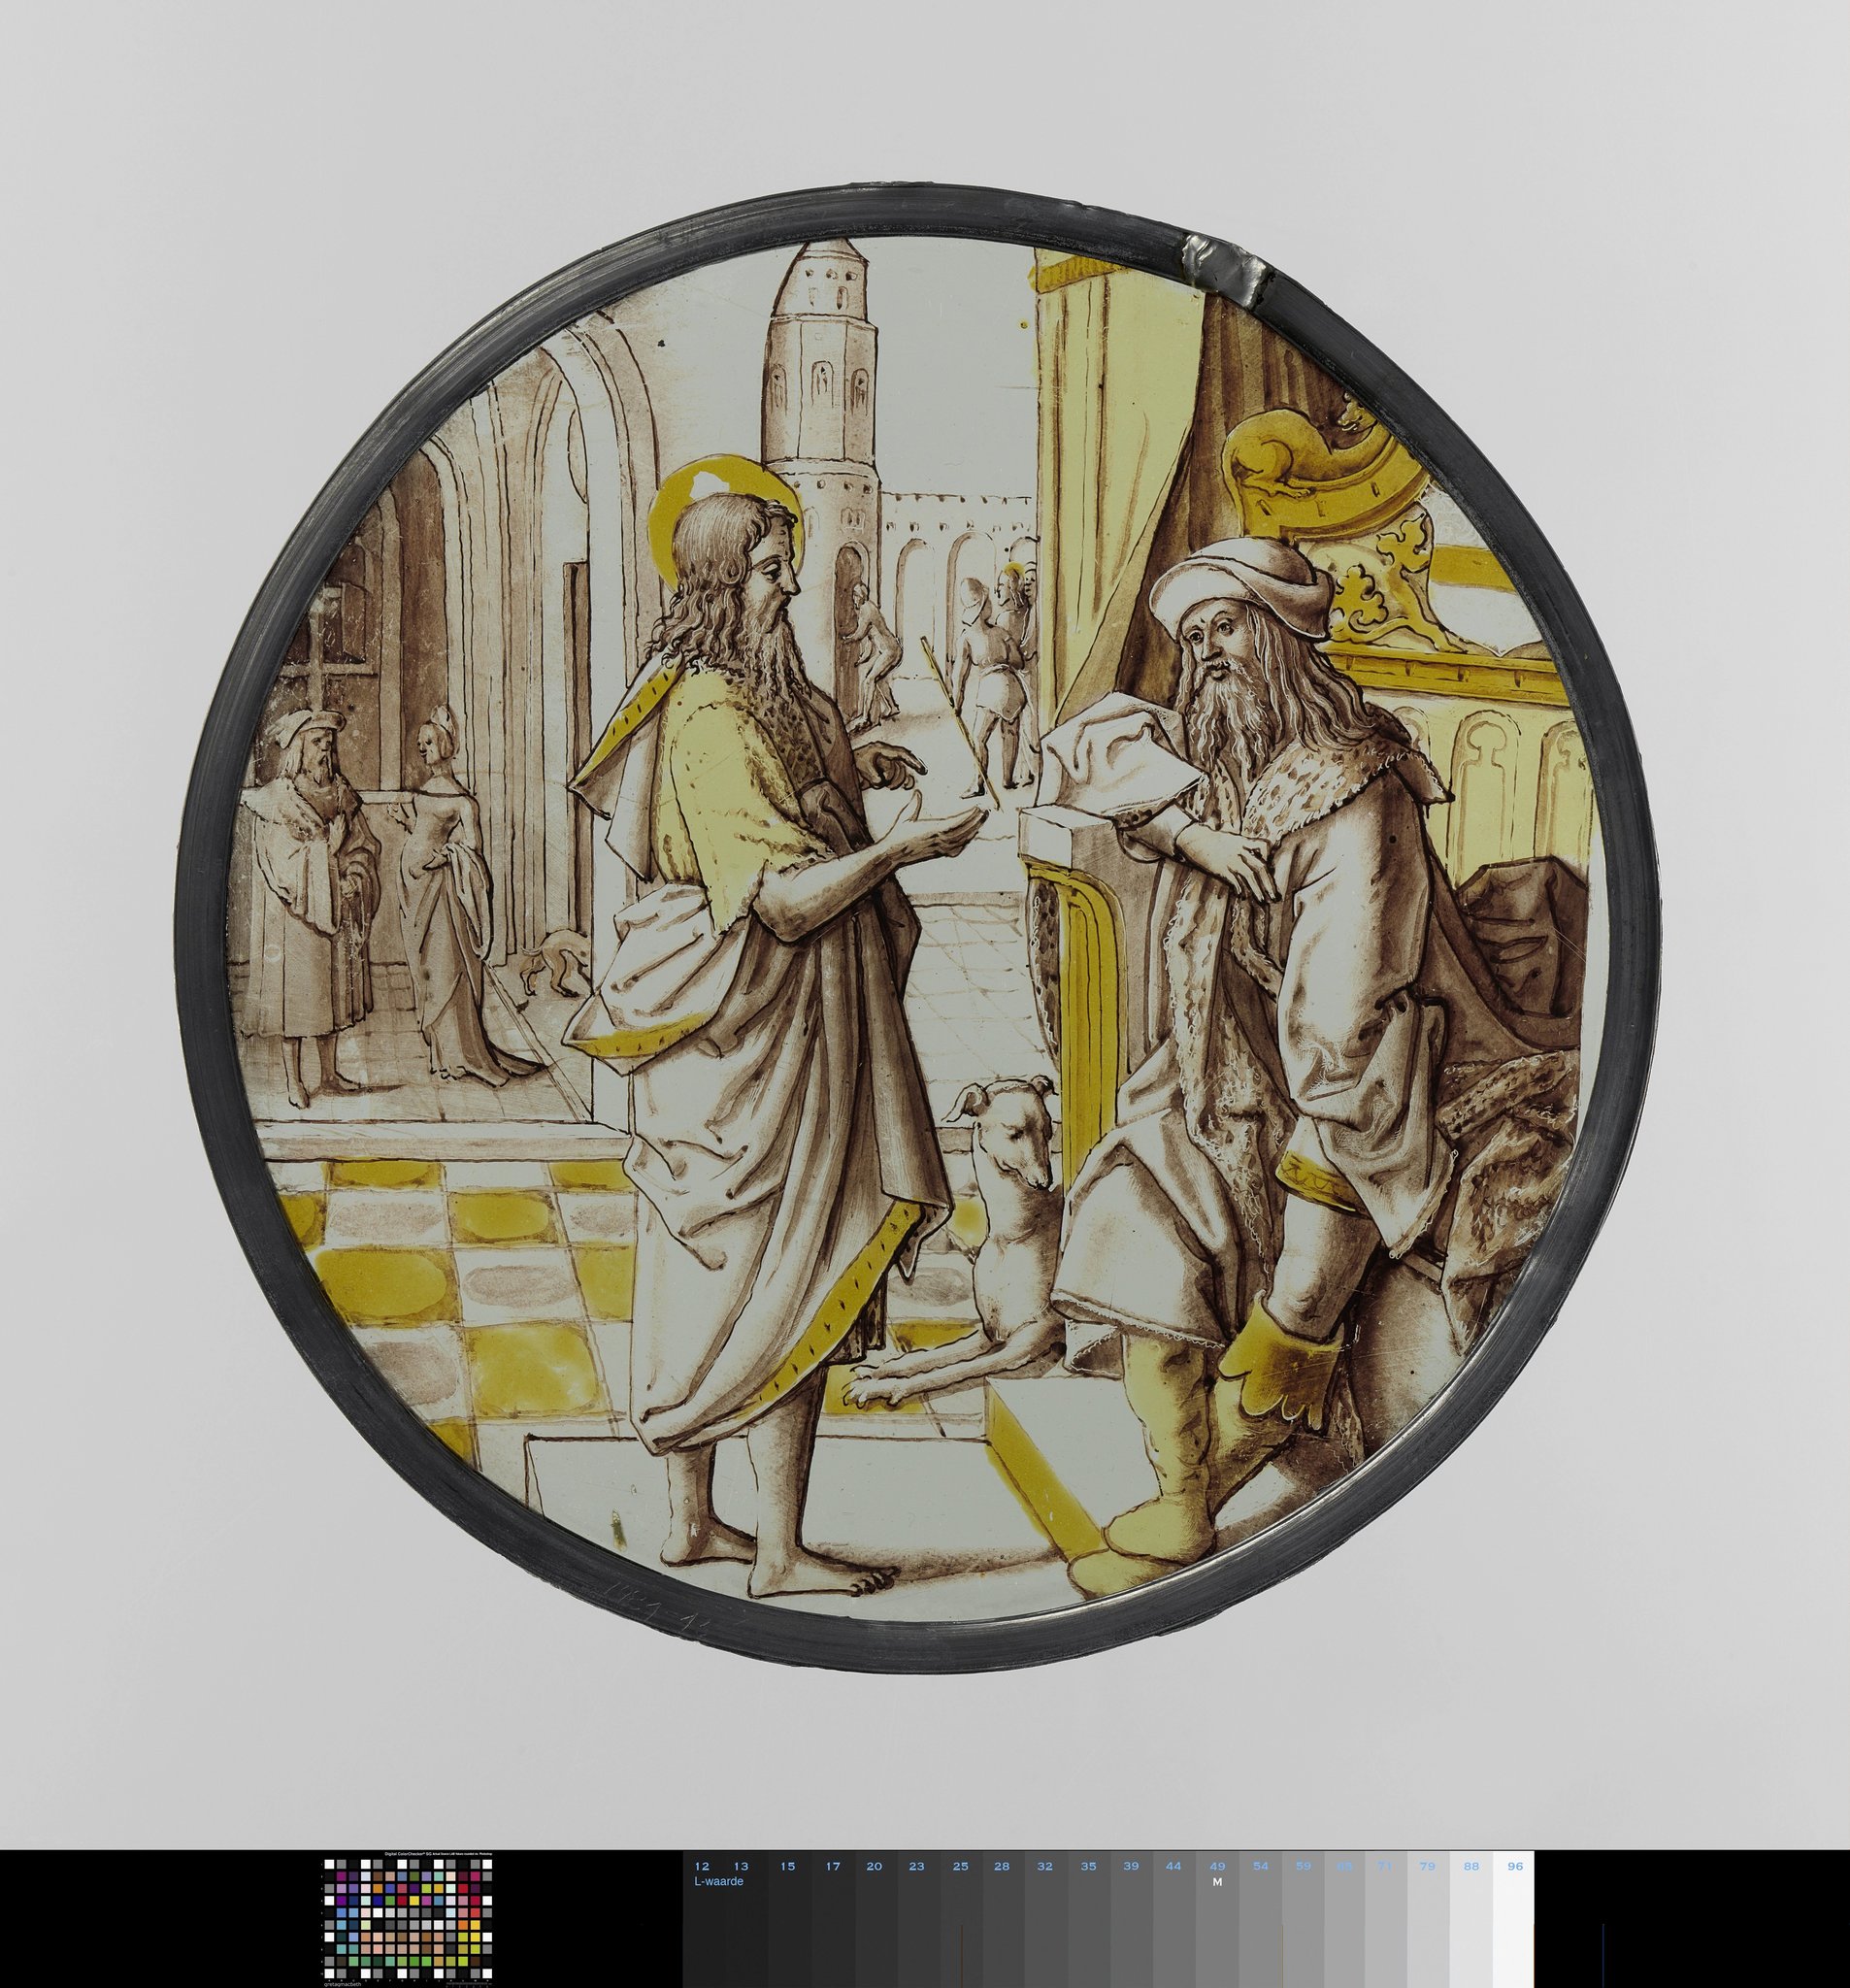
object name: light window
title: Ruit met Johannes de Doper voor Herodes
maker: Anonymous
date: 1510-1530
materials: glass, lead, pigment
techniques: leading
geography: leiden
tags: john the baptist reproaches herod (herod antipas) and herodias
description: St John the Baptist Before Herod. Stained glass. Leiden, c. 1520 - 1530. Acquired by the Rijksmuseum Foundation.